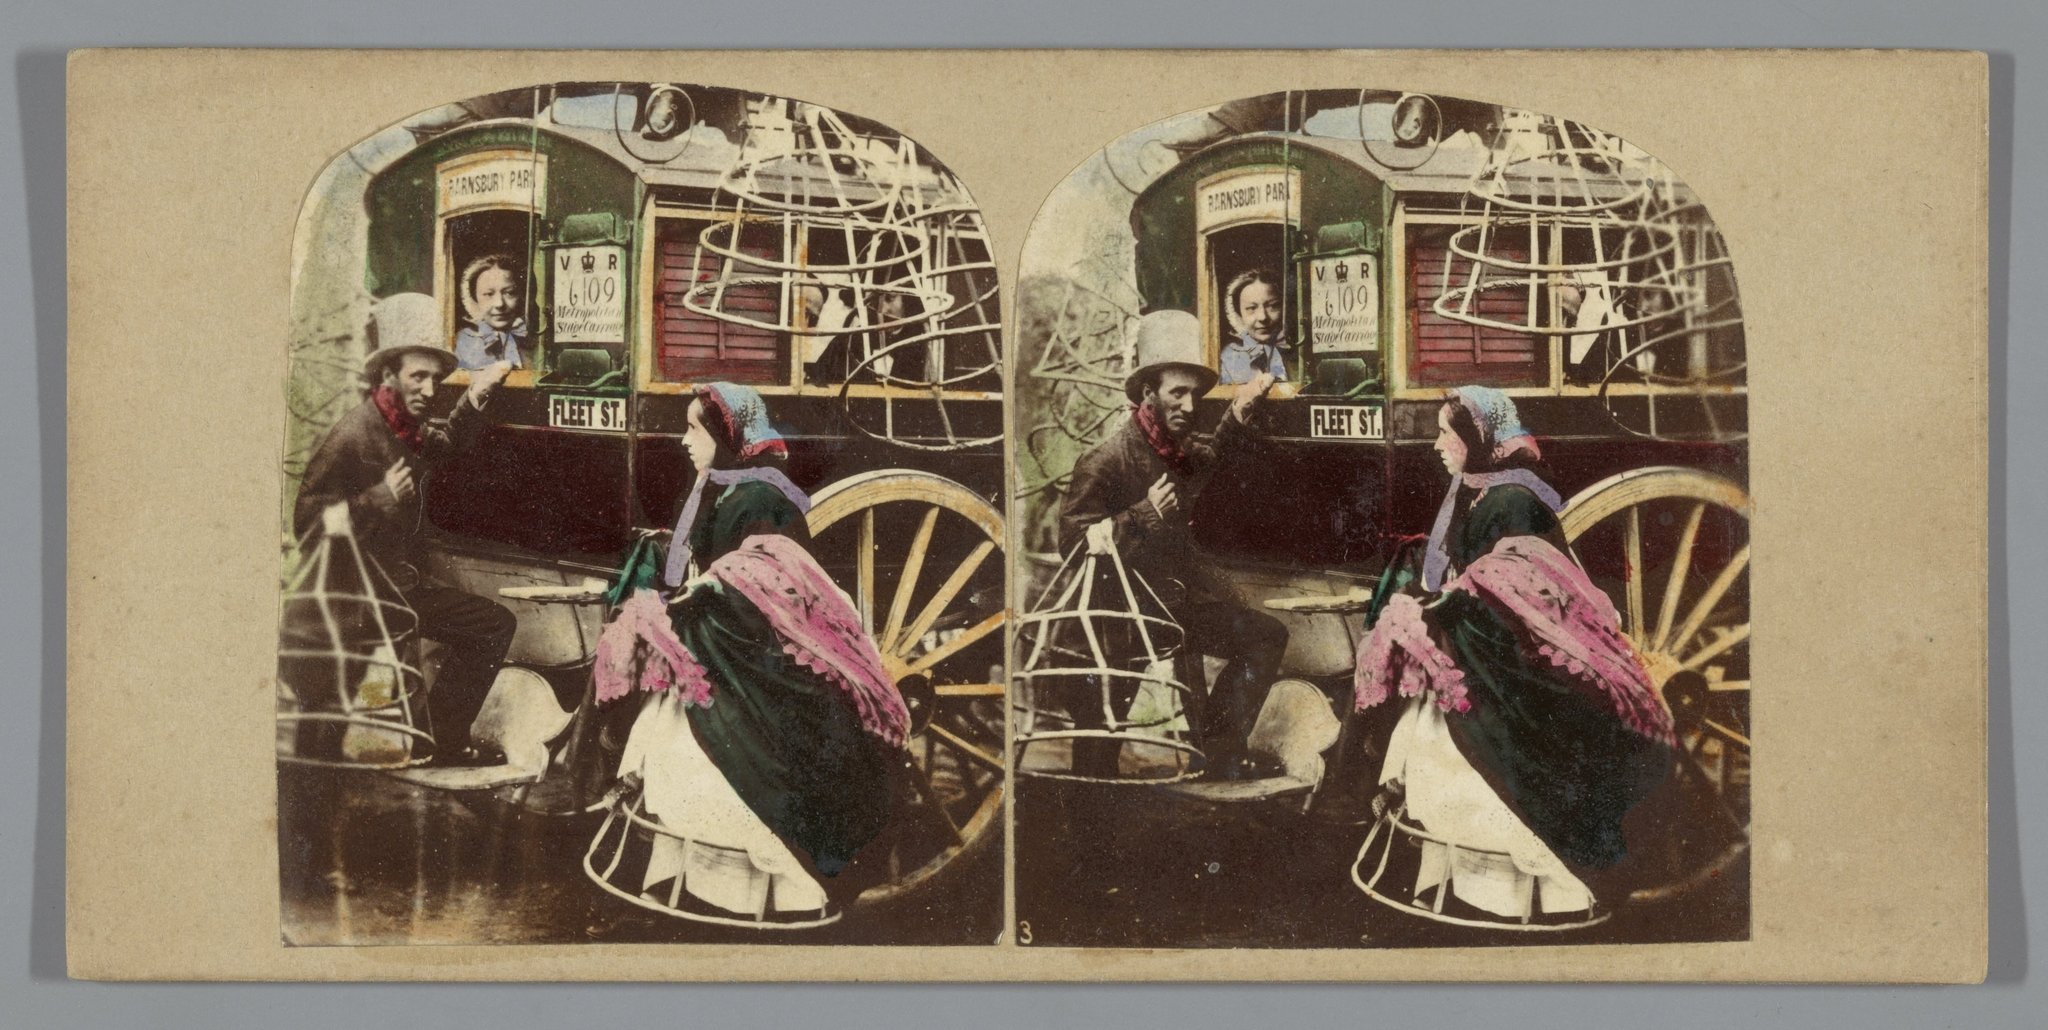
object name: stereograph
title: Vrouw moet haar hoepelrok uitdoen om de tram te betreden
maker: Anonymous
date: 1852-1863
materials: cardboard, paper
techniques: albumen print, hand coloring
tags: diligence, omnibus, horse-tram, skirt (crinoline skirt) (+ women's clothes)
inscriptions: inscription: ‘3’